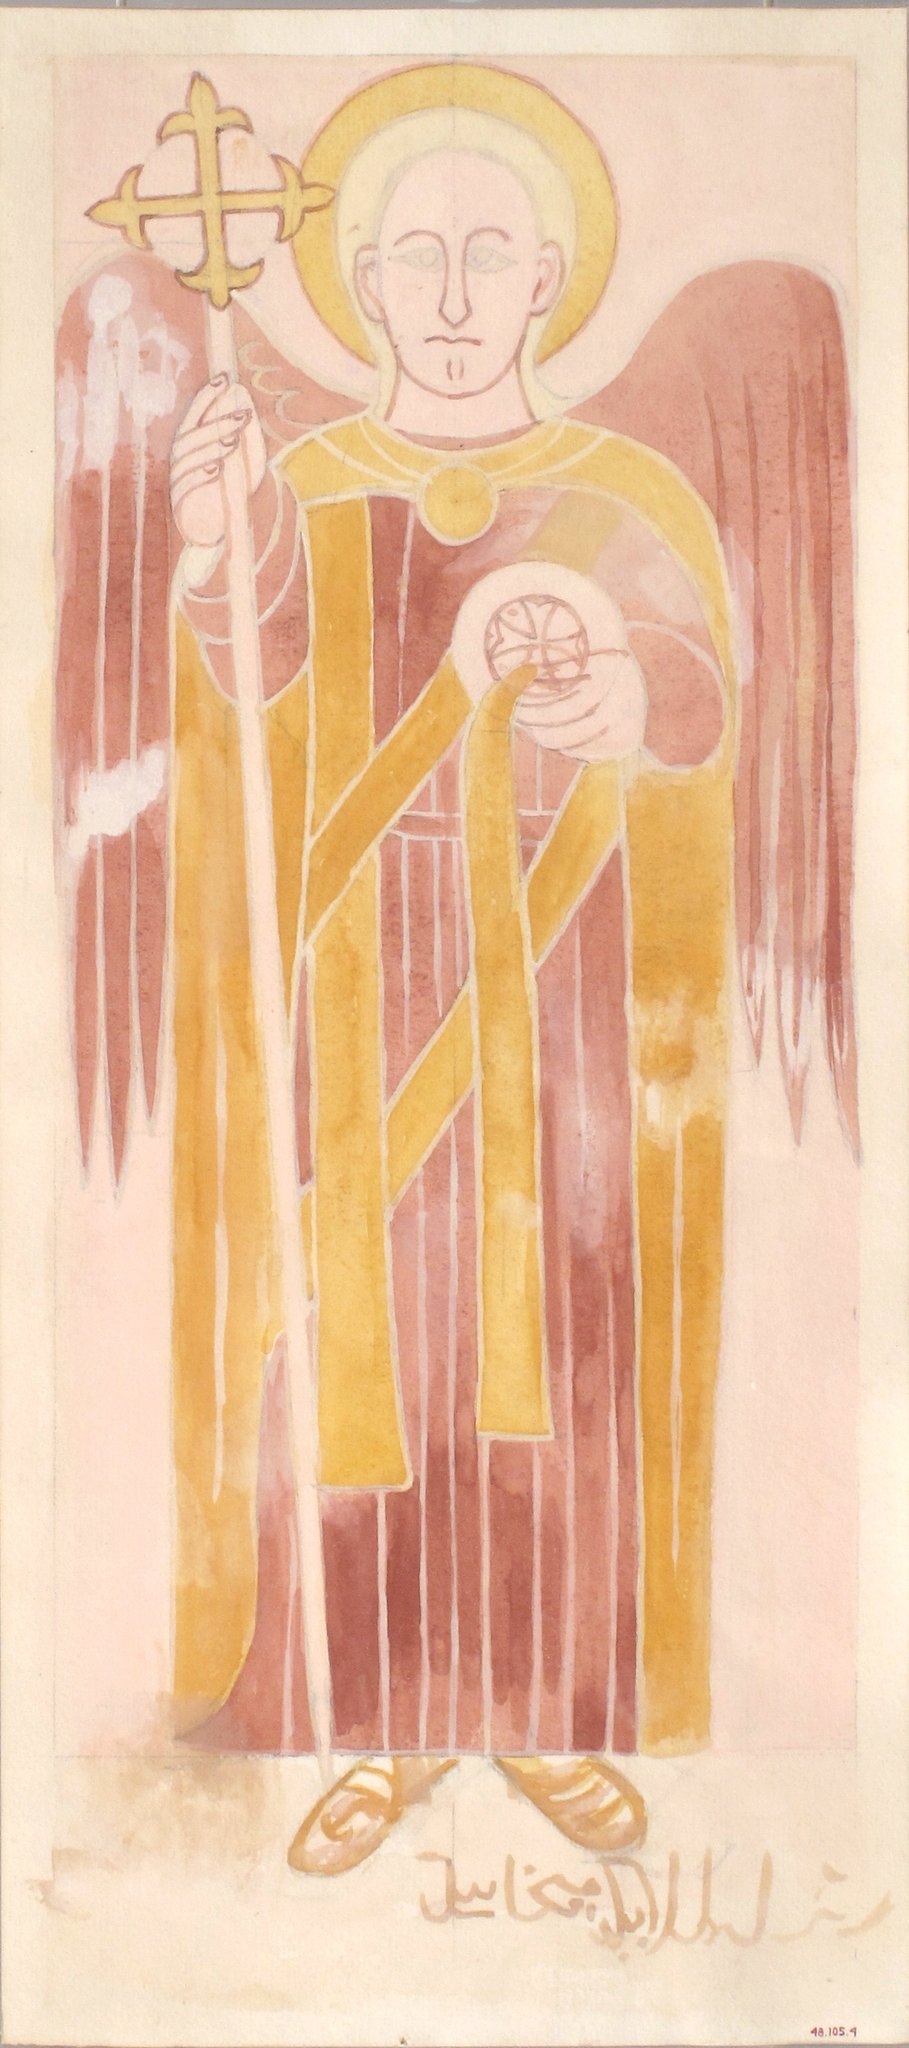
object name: facsimile, st. michael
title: Saint Michael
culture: egyptian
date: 101-600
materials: paper, paint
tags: saint michael